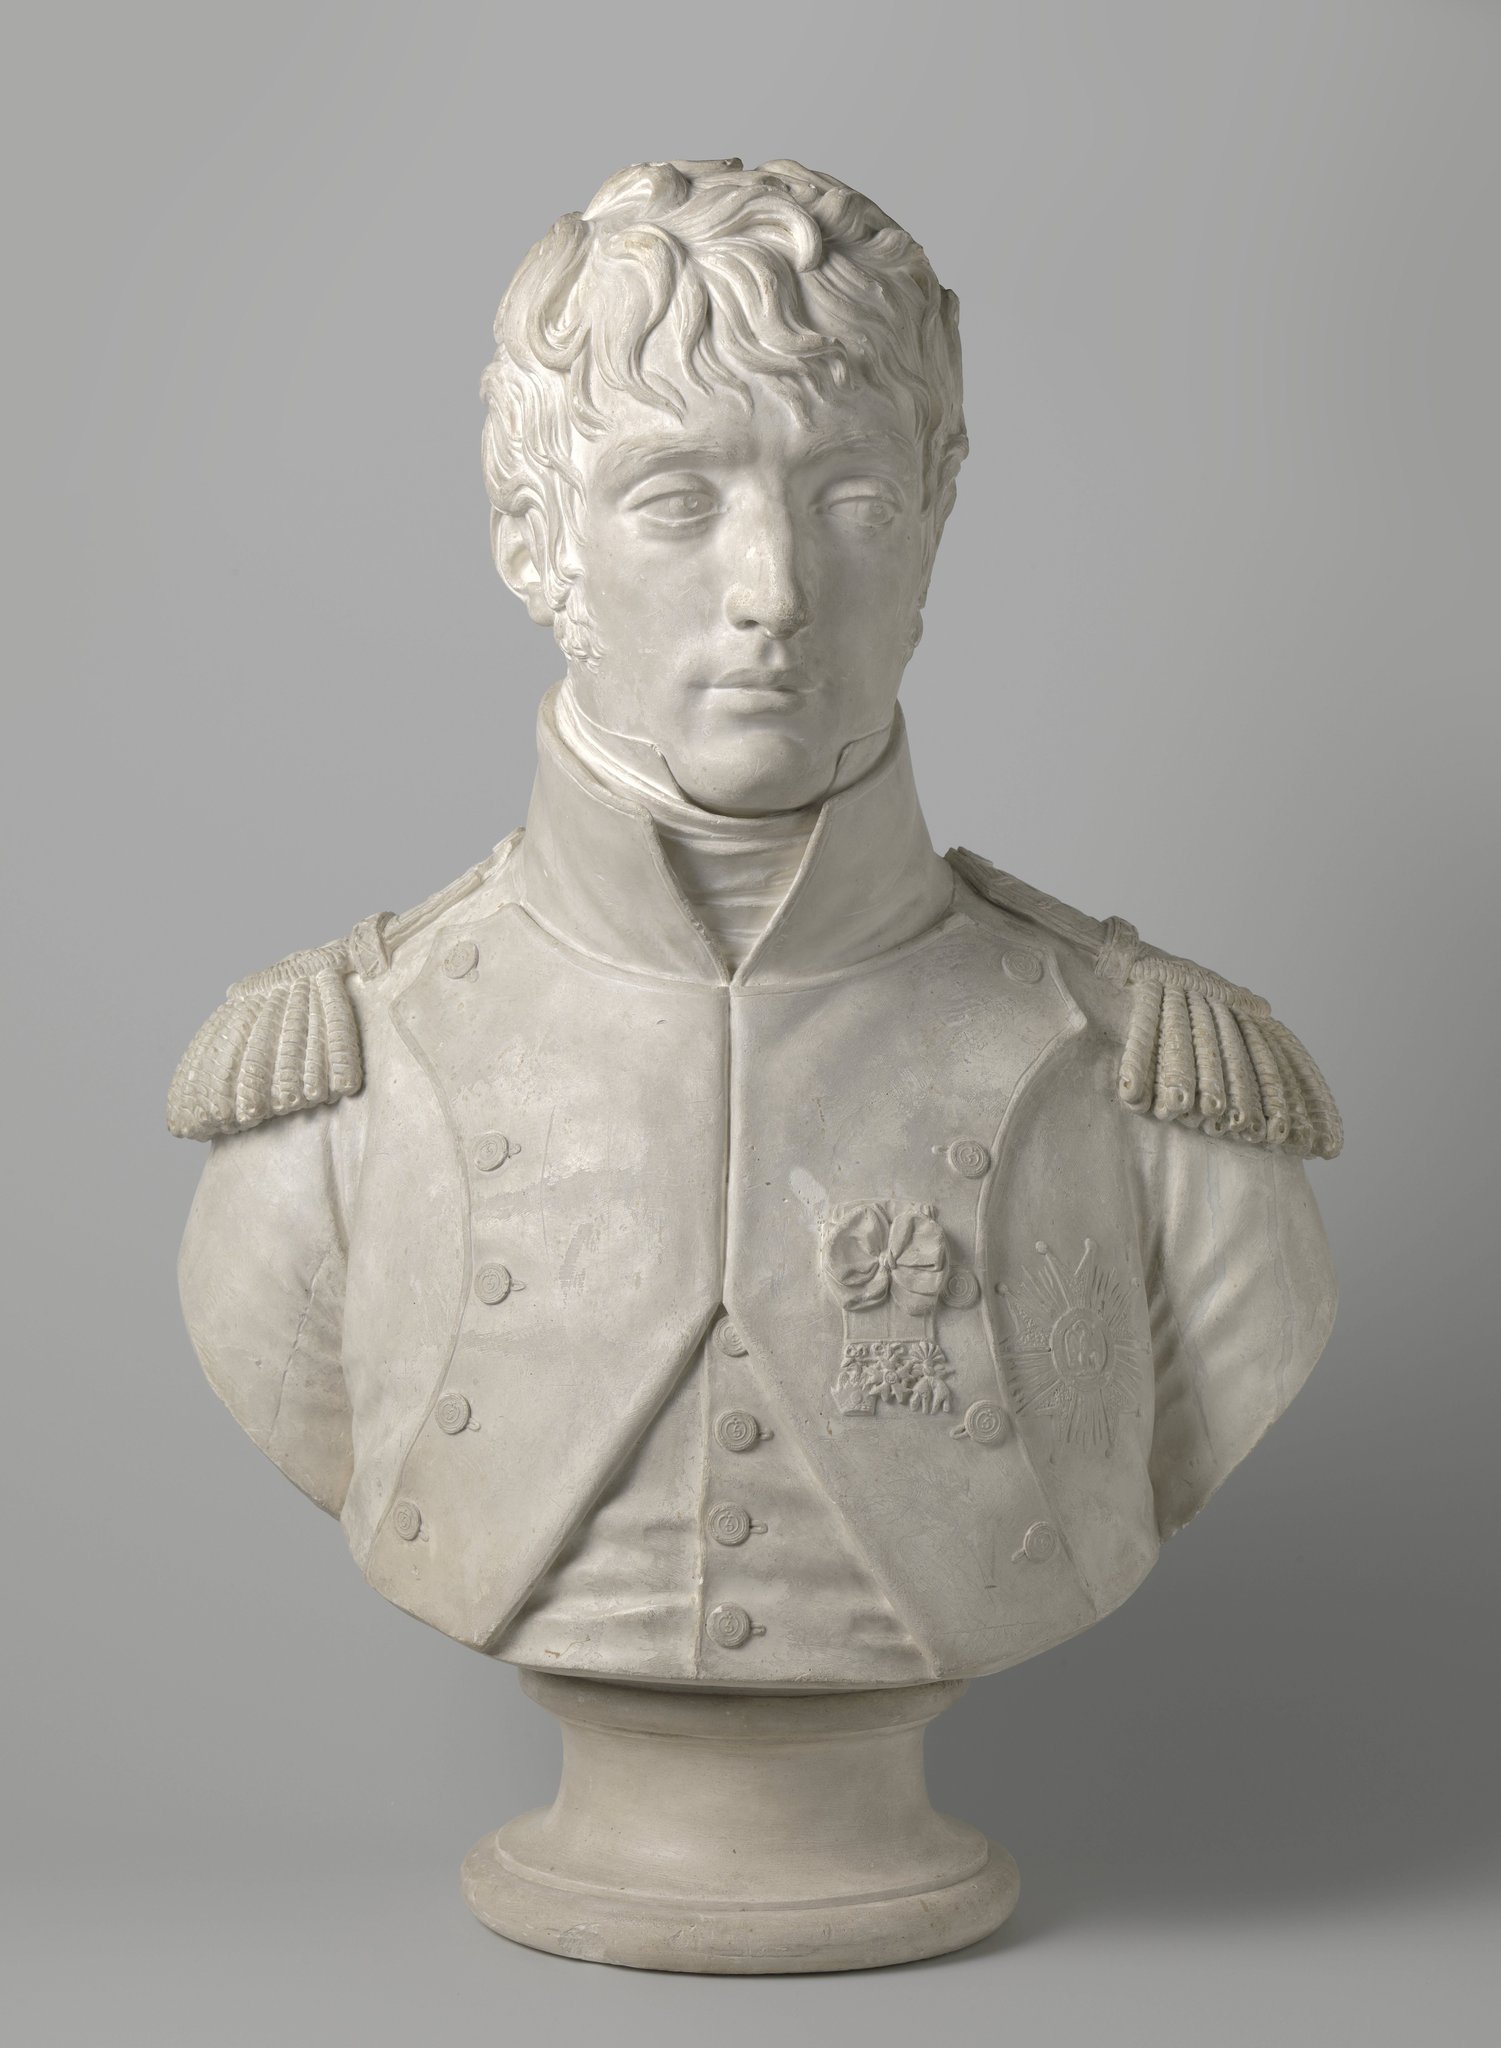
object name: figure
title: Borstbeeld van Lodewijk Napoleon, koning van Holland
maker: pierre cartellier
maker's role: sculptor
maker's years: 1757-1831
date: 1806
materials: gypsum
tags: louis napoleon (king of holland)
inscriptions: signature and date: ‘P. Cartellier. 1806’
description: Borstbeeld van Lodewijk Napoleon, koning van Holland.